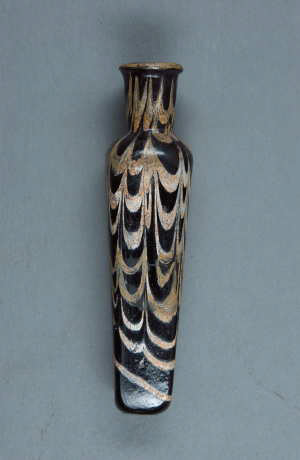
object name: kohl flask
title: Cosmetic Flask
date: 1201-1300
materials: amber, glass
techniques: glassblowing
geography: egypt or syria